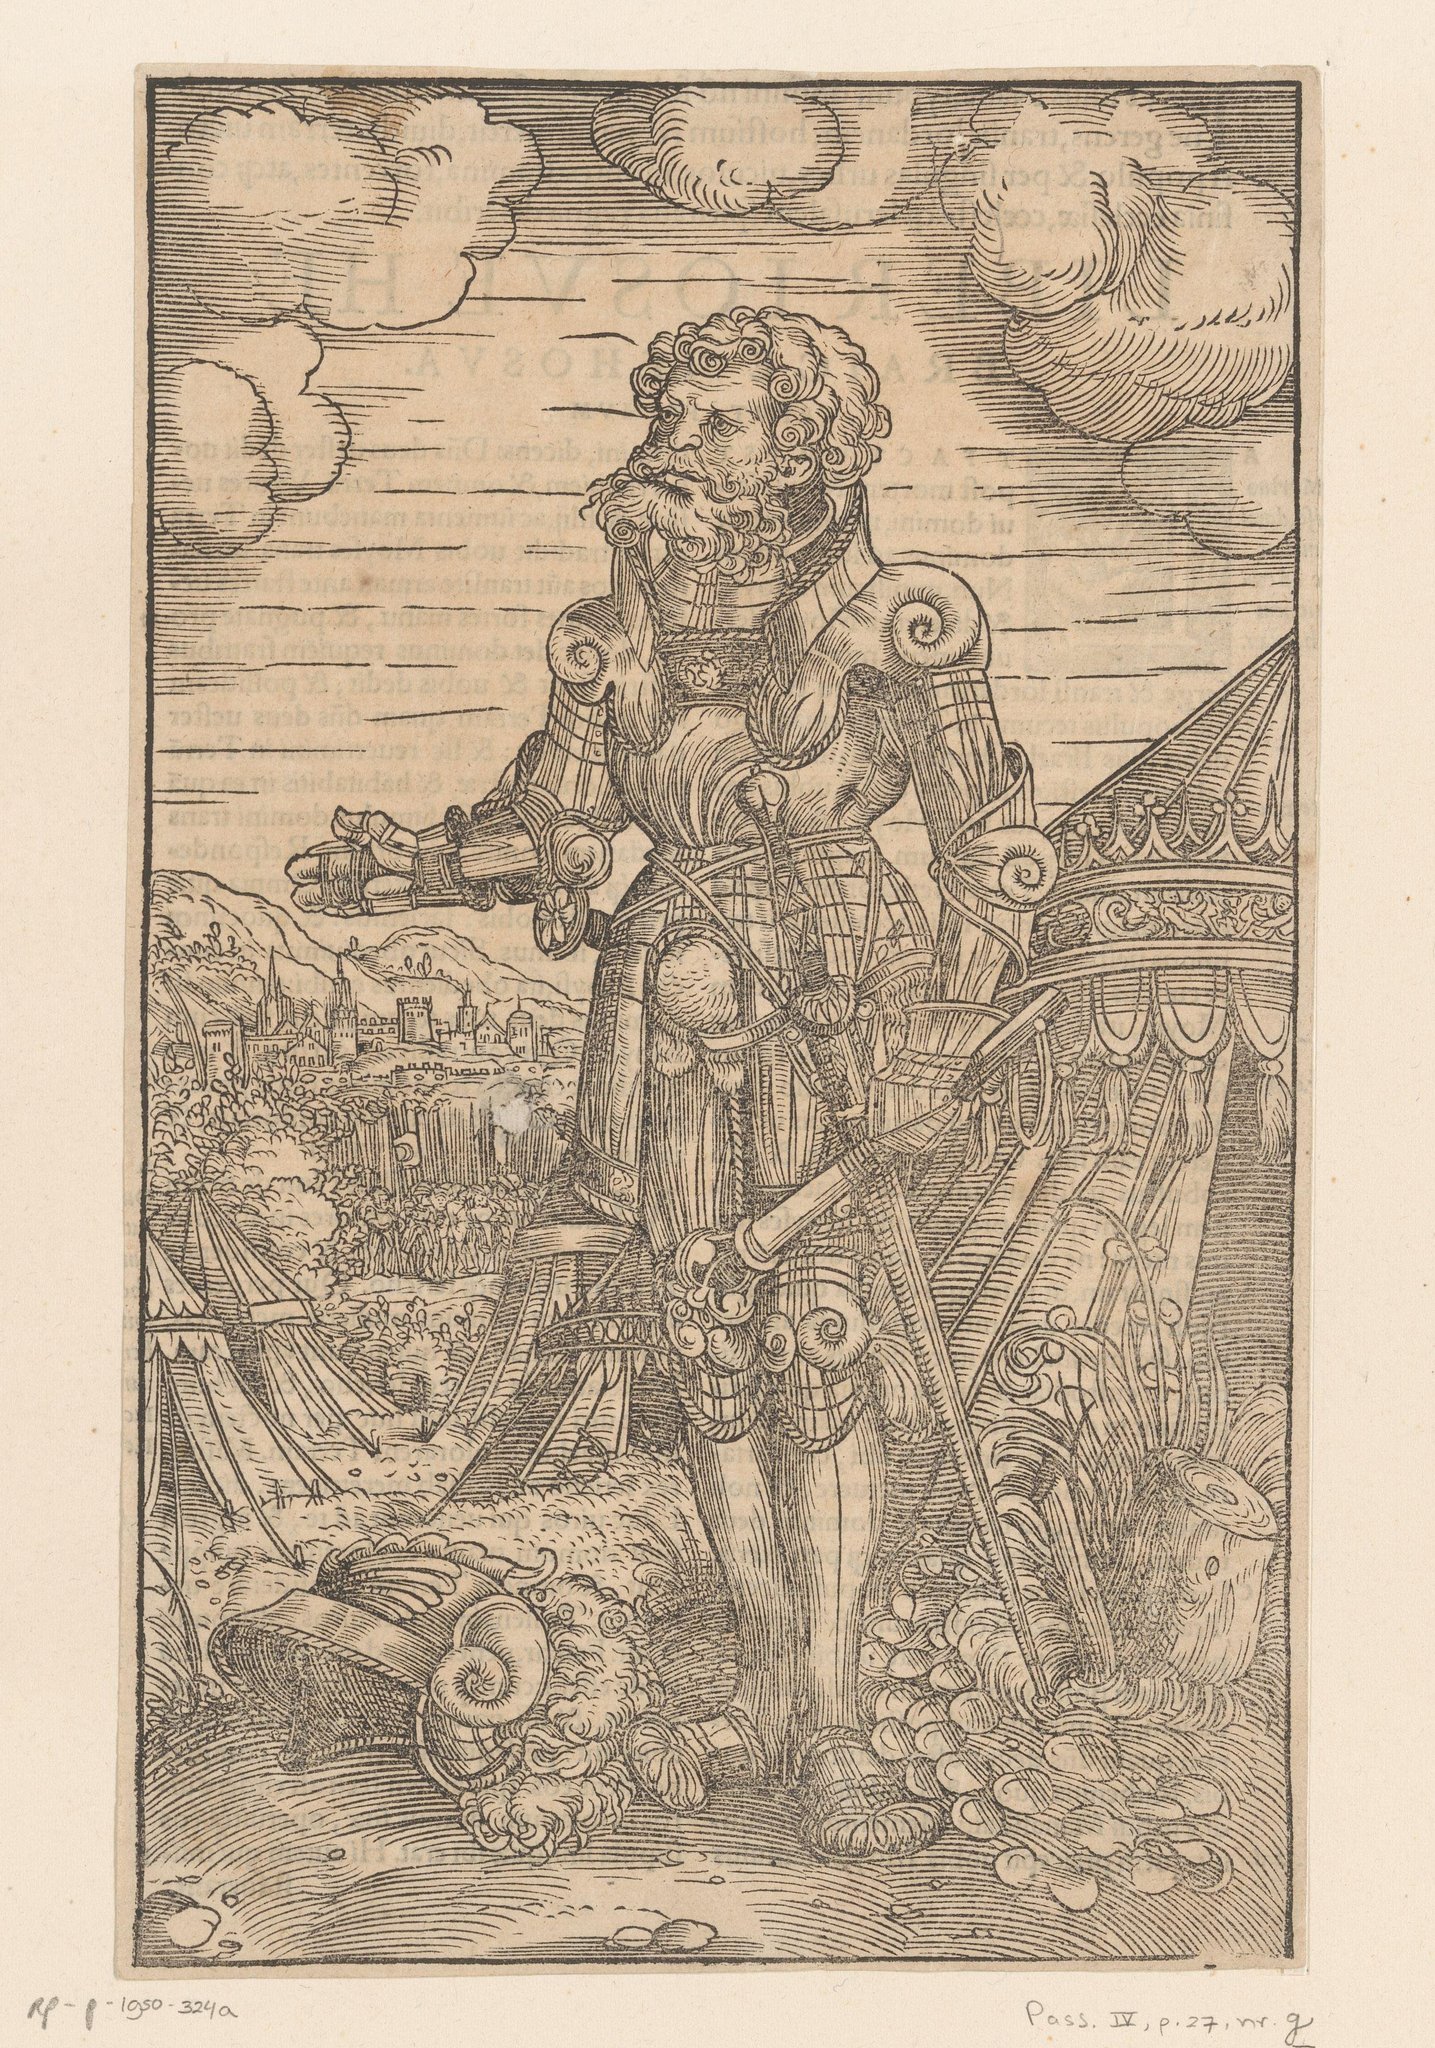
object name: book illustration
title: Jozua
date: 1541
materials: paper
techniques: woodcut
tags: joshua (not in biblical context)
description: Prent afkomstig uit: Luther, Martin. Die Propheten alle deudsch (...). Leipzig: Nicolaus Wolrab, 1541.